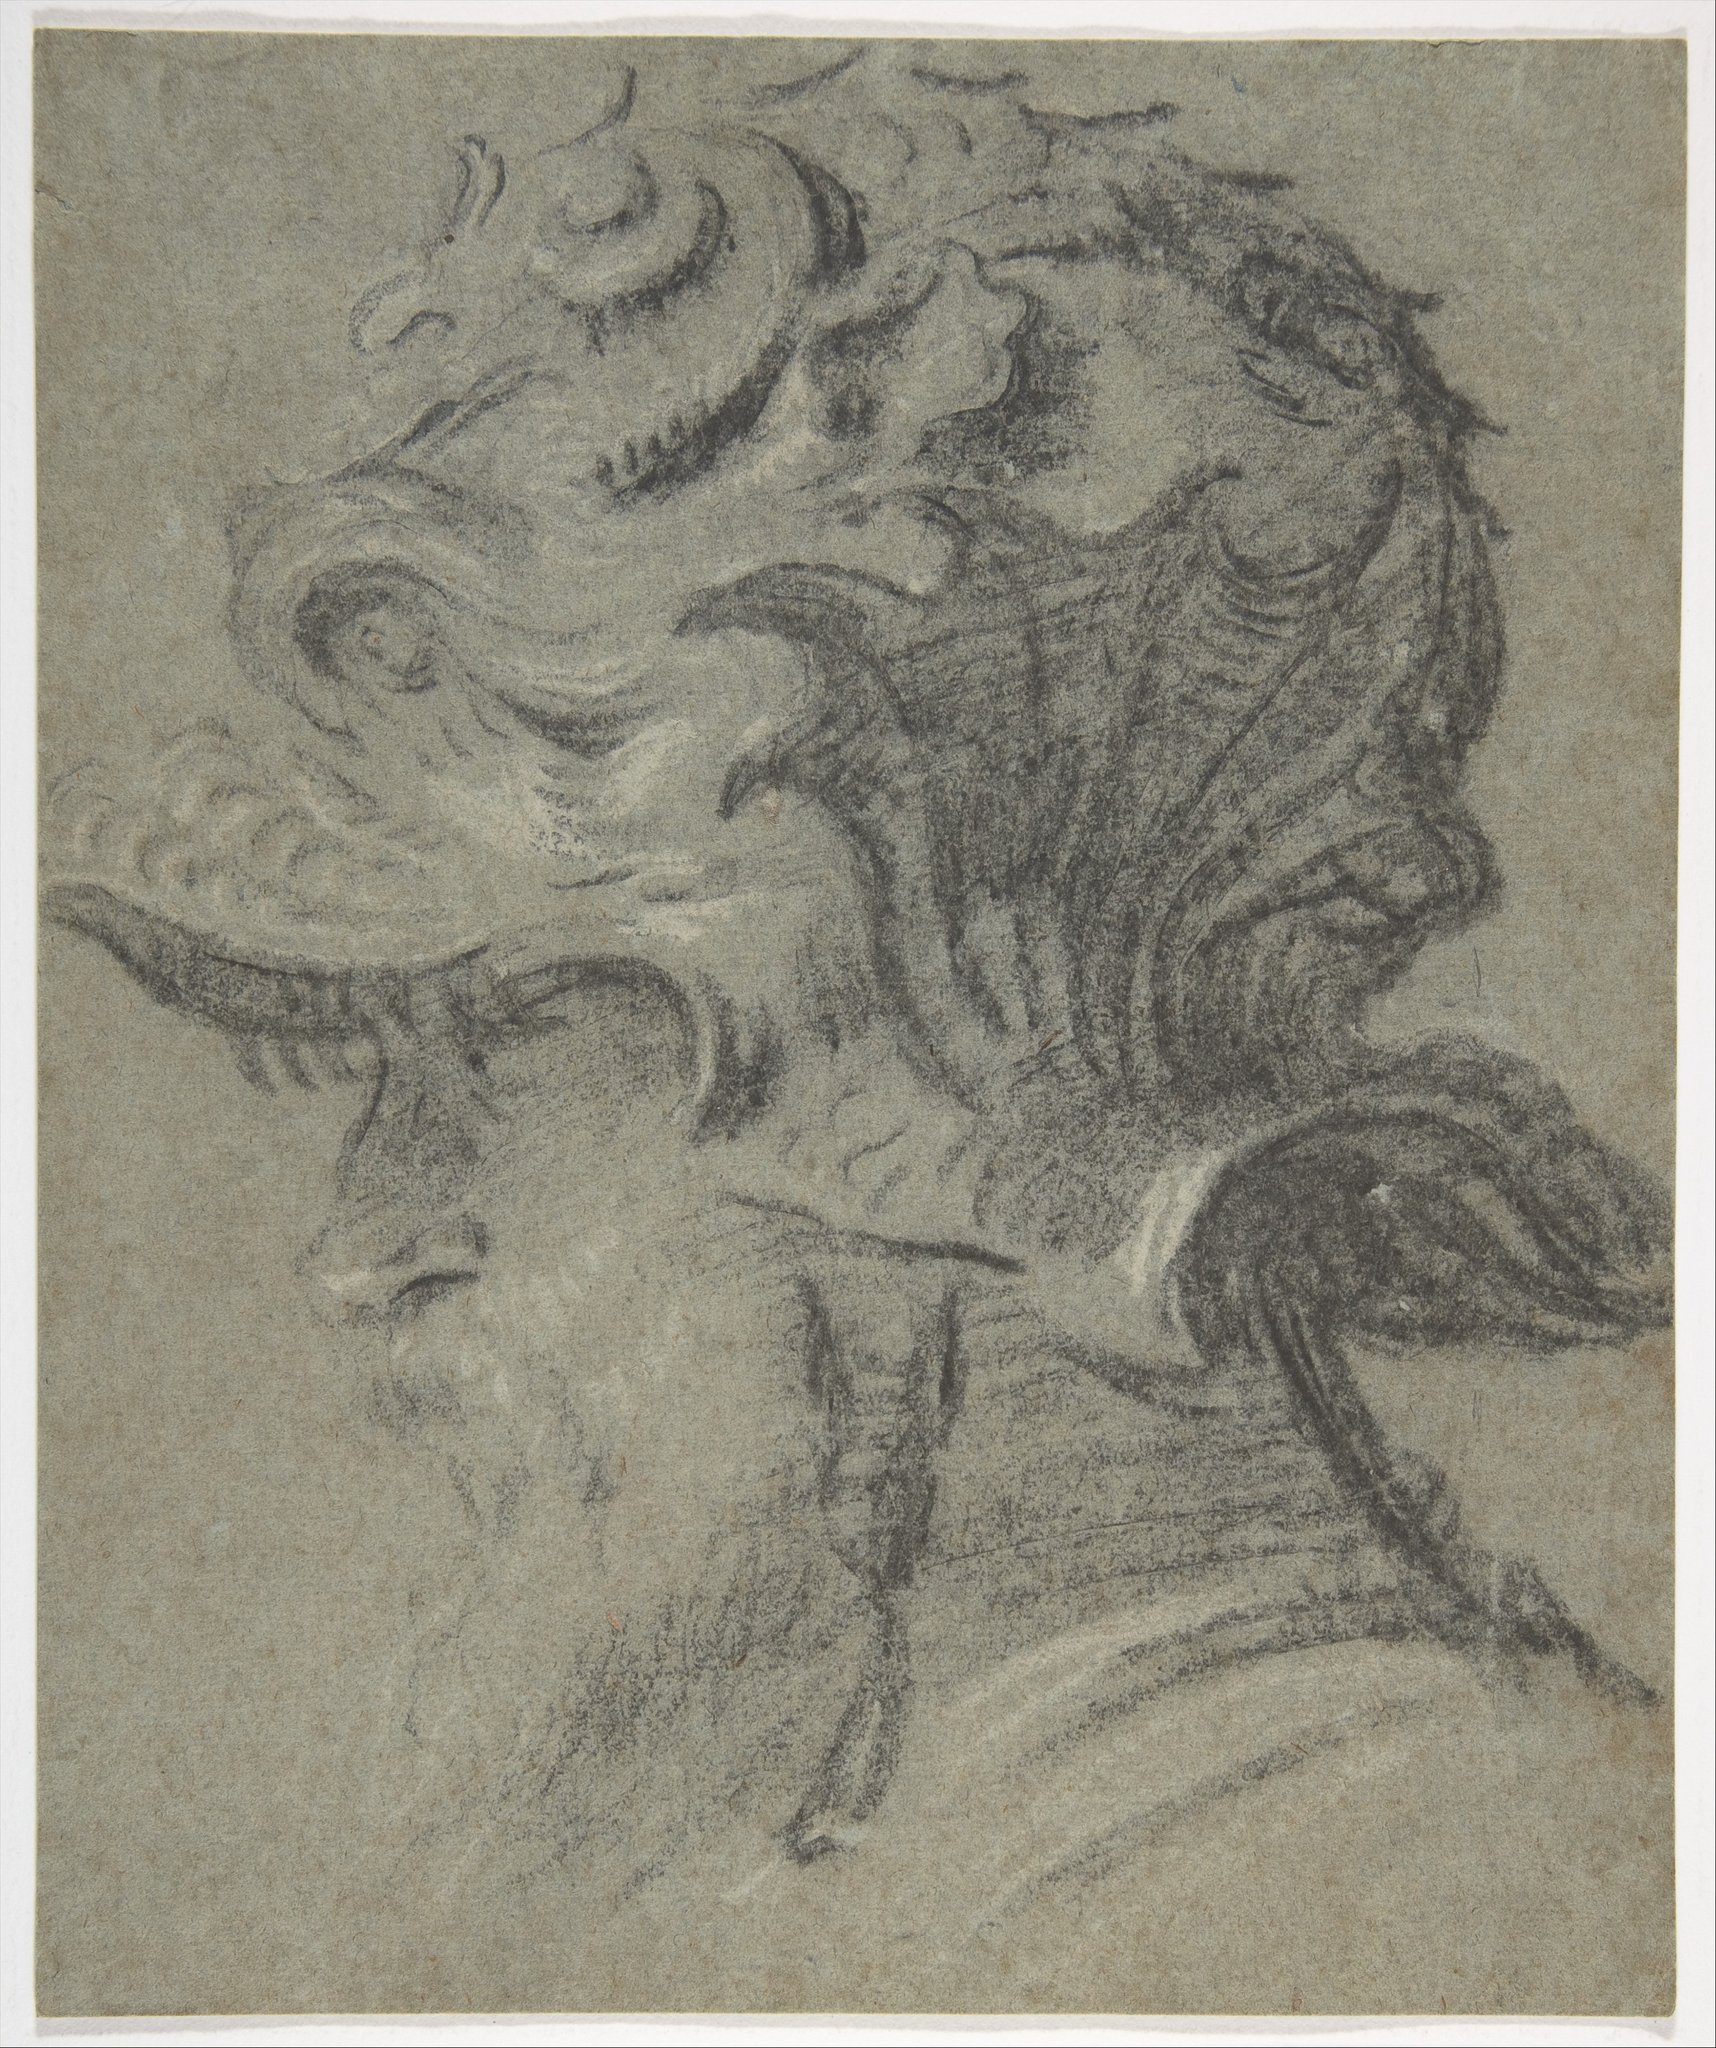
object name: drawing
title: Study of a Bearded Man Wearing the Helmet of Guidobaldo II della Rovere, Duke of Urbino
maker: anonymous, italian, venetian, 16th century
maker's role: artist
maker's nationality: italian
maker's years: 1500-1600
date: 1536-1540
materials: chalk, charcoal, paper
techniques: highlighting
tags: helmets,men